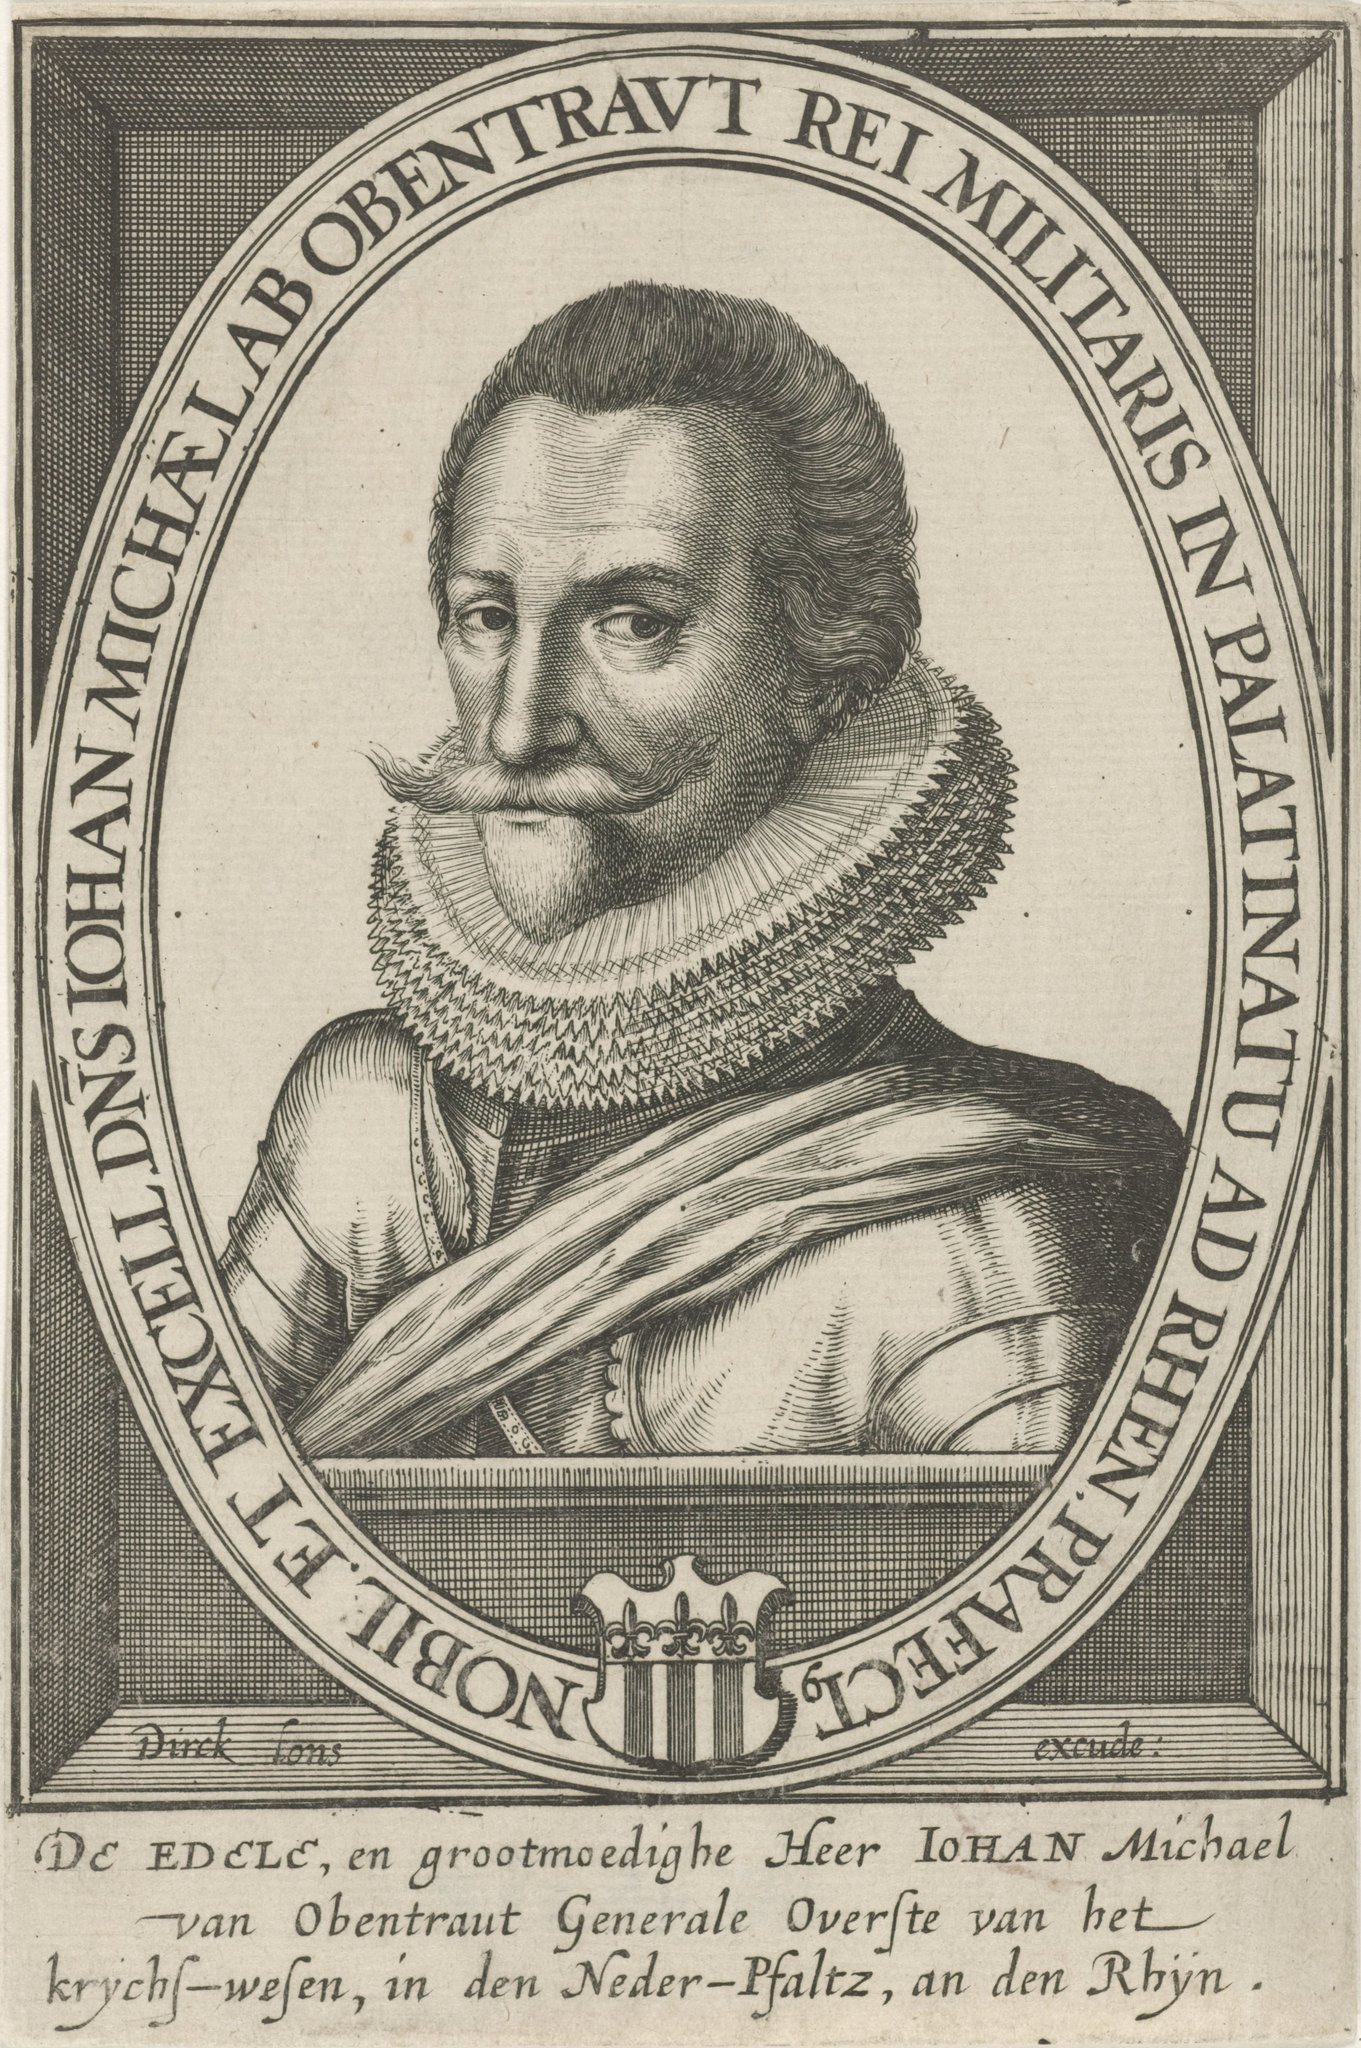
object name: print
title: Portret van Hans Michael Elias von Obentraut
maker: dirk eversen lons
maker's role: print maker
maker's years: 1599-1686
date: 1609-1686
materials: paper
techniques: engraving, letterpress printing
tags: stromberg, hannover, generaal, hans michael elias von obentraut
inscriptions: collector's mark: Lugt 240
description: Portret van de Duitse generaal Hans Michael Elias von Obentraut. Met familiewapen en een drieregelig onderschrift.